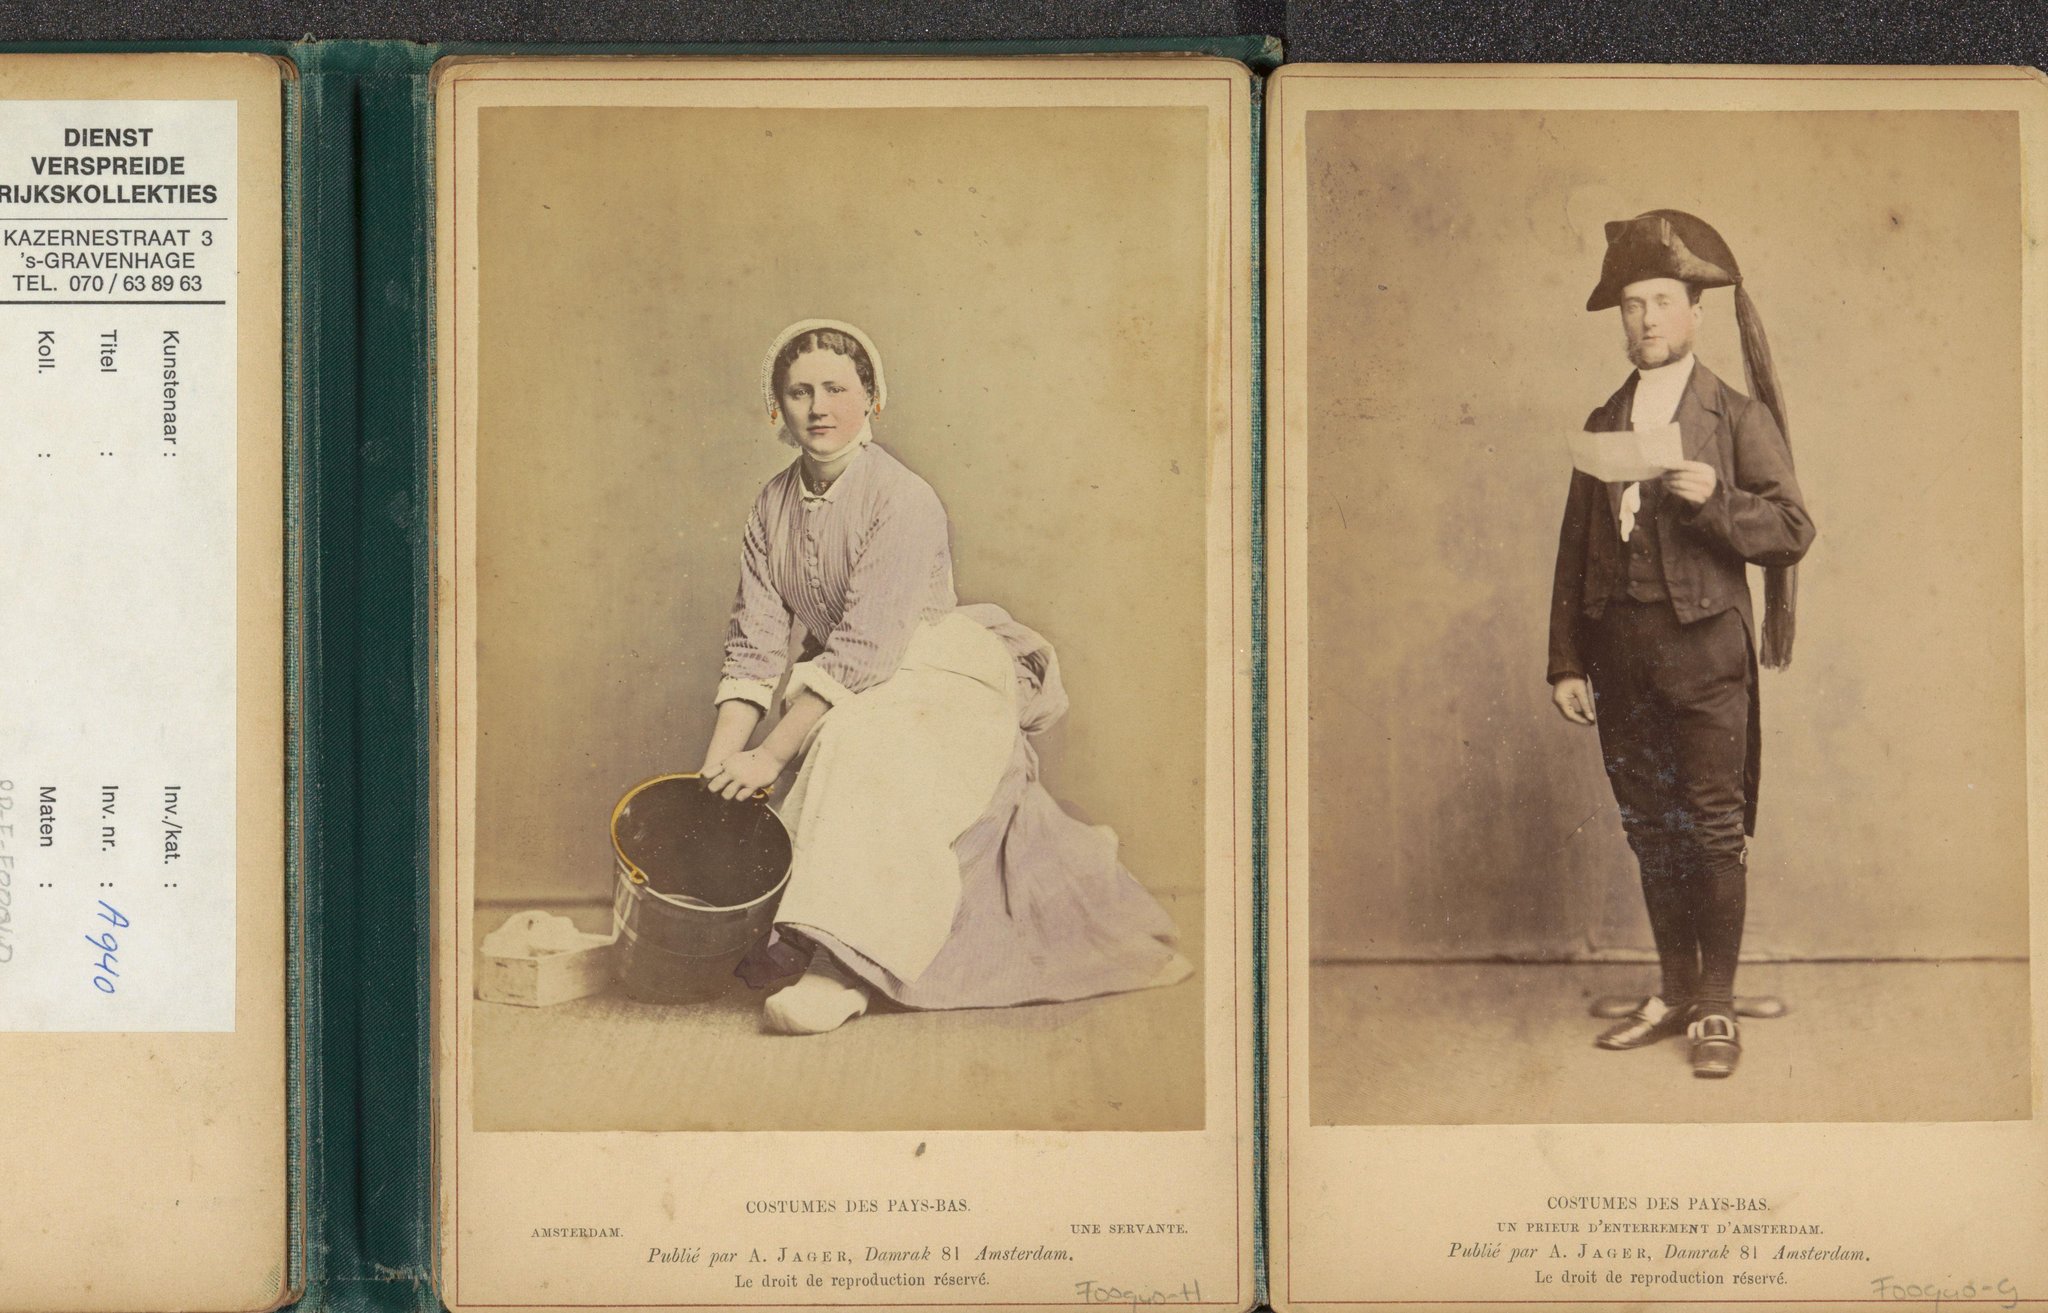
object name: photograph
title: Amsterdam. Une servante.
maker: andries jager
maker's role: publisher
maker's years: 1825-1905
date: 1870-1890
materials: cardboard, paper, photographic support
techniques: albumen print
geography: amsterdam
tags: folk costume, regional costume (+ women's clothes), wooden container: barrel, cask (+ wood and other phytogenic material), folk costume, regional costume, house personnel, servants, amsterdam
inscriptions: inscription: ‘Costumes des Pays-Bas. Publiés par A. Jager, Damrak 81 Amsterdam Le droit de reproduction réservé.’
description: Onderdeel van Fotoalbum met klederdrachten van Nederland.